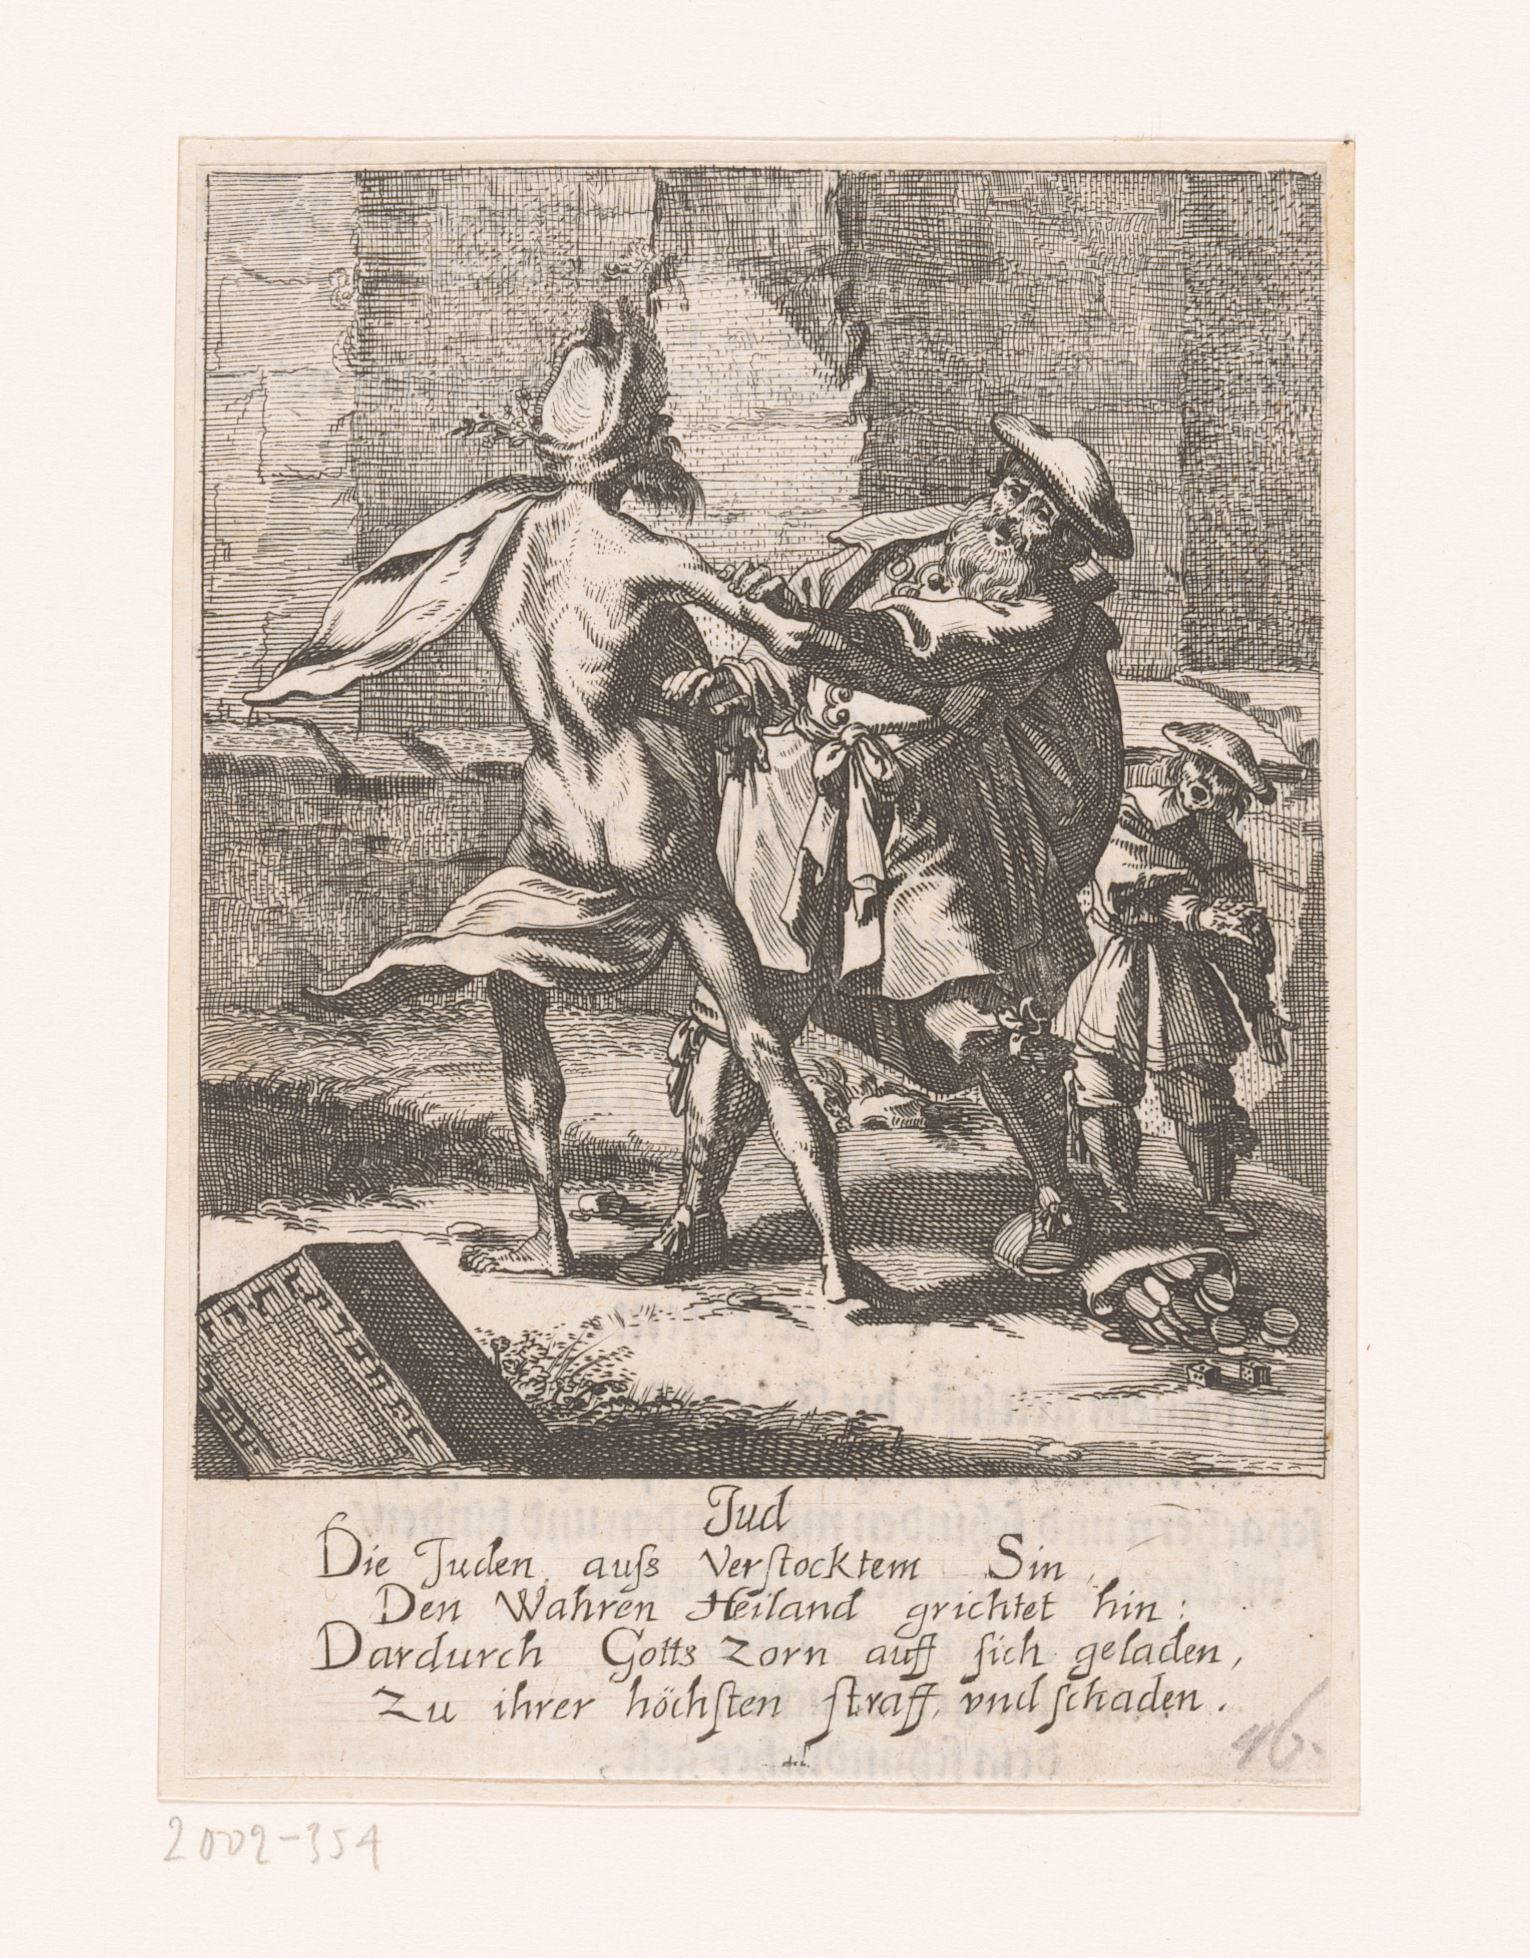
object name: print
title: De Dodendans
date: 1650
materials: paper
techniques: etching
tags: personifications of death; 'morte' (ripa), dance of death; death together with one or more human beings, the jews, jewish life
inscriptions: collector's mark: Lugt 2233, collector's mark: Lugt 2228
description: Een Jood (te herkennen aan de cirkel op zijn wambuis) in een worsteling met de Dood in de gedaante van een magere naakte man met soort tulband op. naast hem op de grond een zak geldstukken. Achter hem een kind.